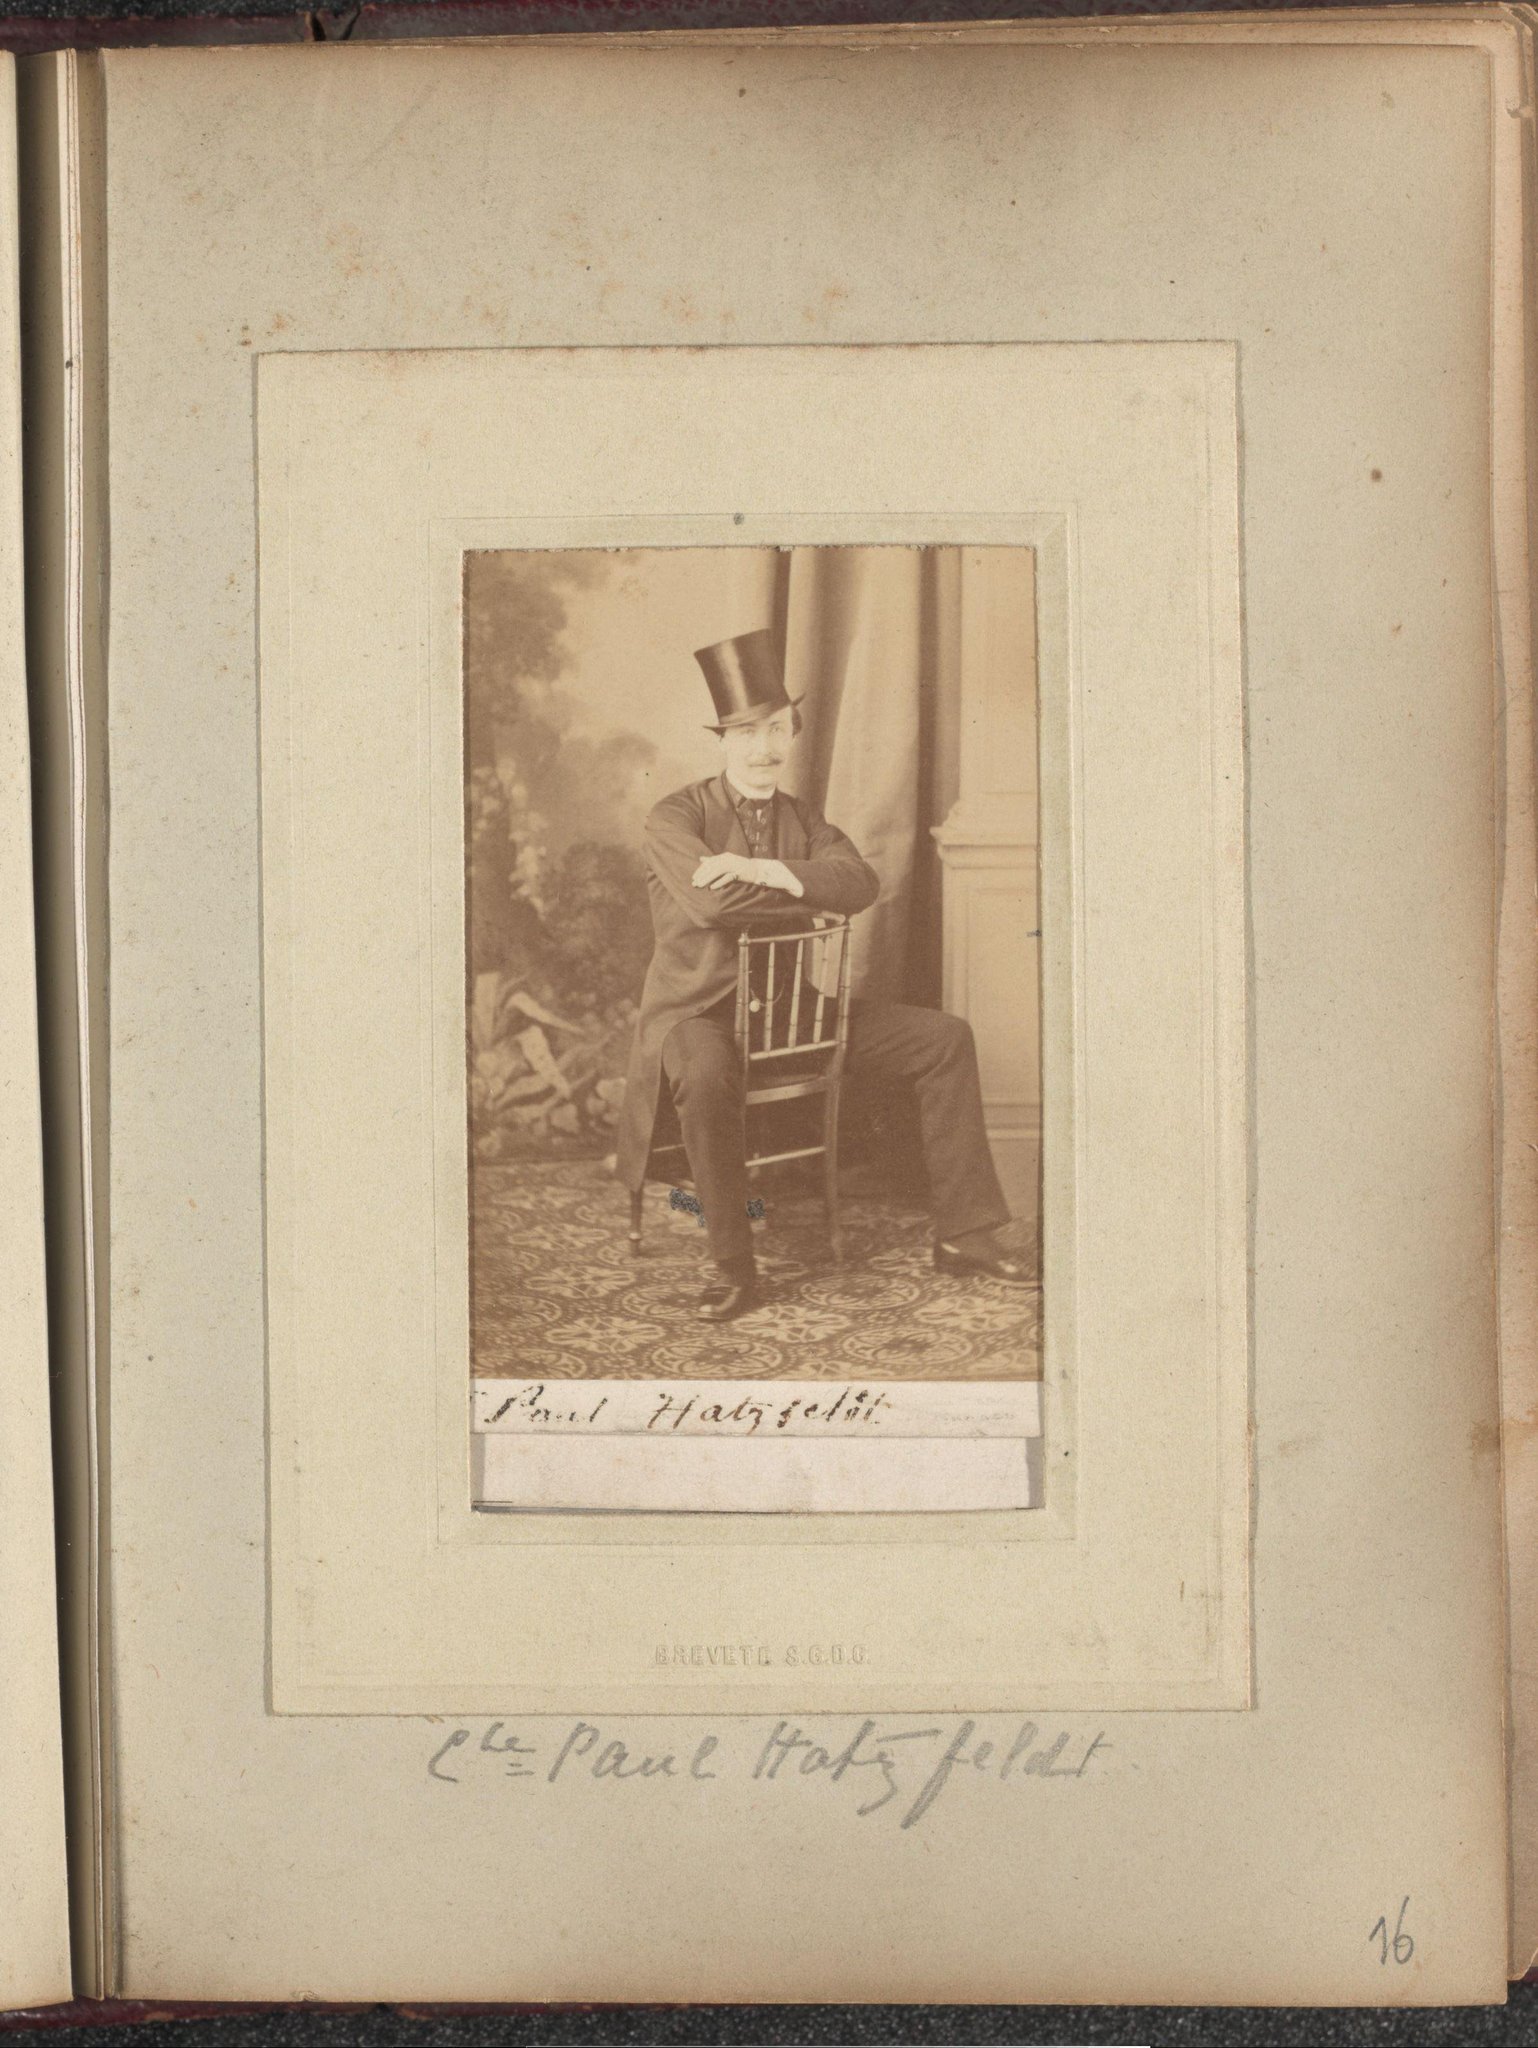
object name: carte de visite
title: Portret van Paul von Hatzfeldt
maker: Anonymous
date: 1860-1865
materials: cardboard, paper, photographic support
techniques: albumen print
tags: london, studio requisites ~ photographer, trousers, breeches, moustache, historical persons, shoes, sandals, chair, coat, cape, head-gear: top hat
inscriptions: name: ‘[...]te Paul Hatzfeldt’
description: Onderdeel van Fotoalbum met 48 cartes-de-visite aangeboden aan maarschalk graaf De Castellane.